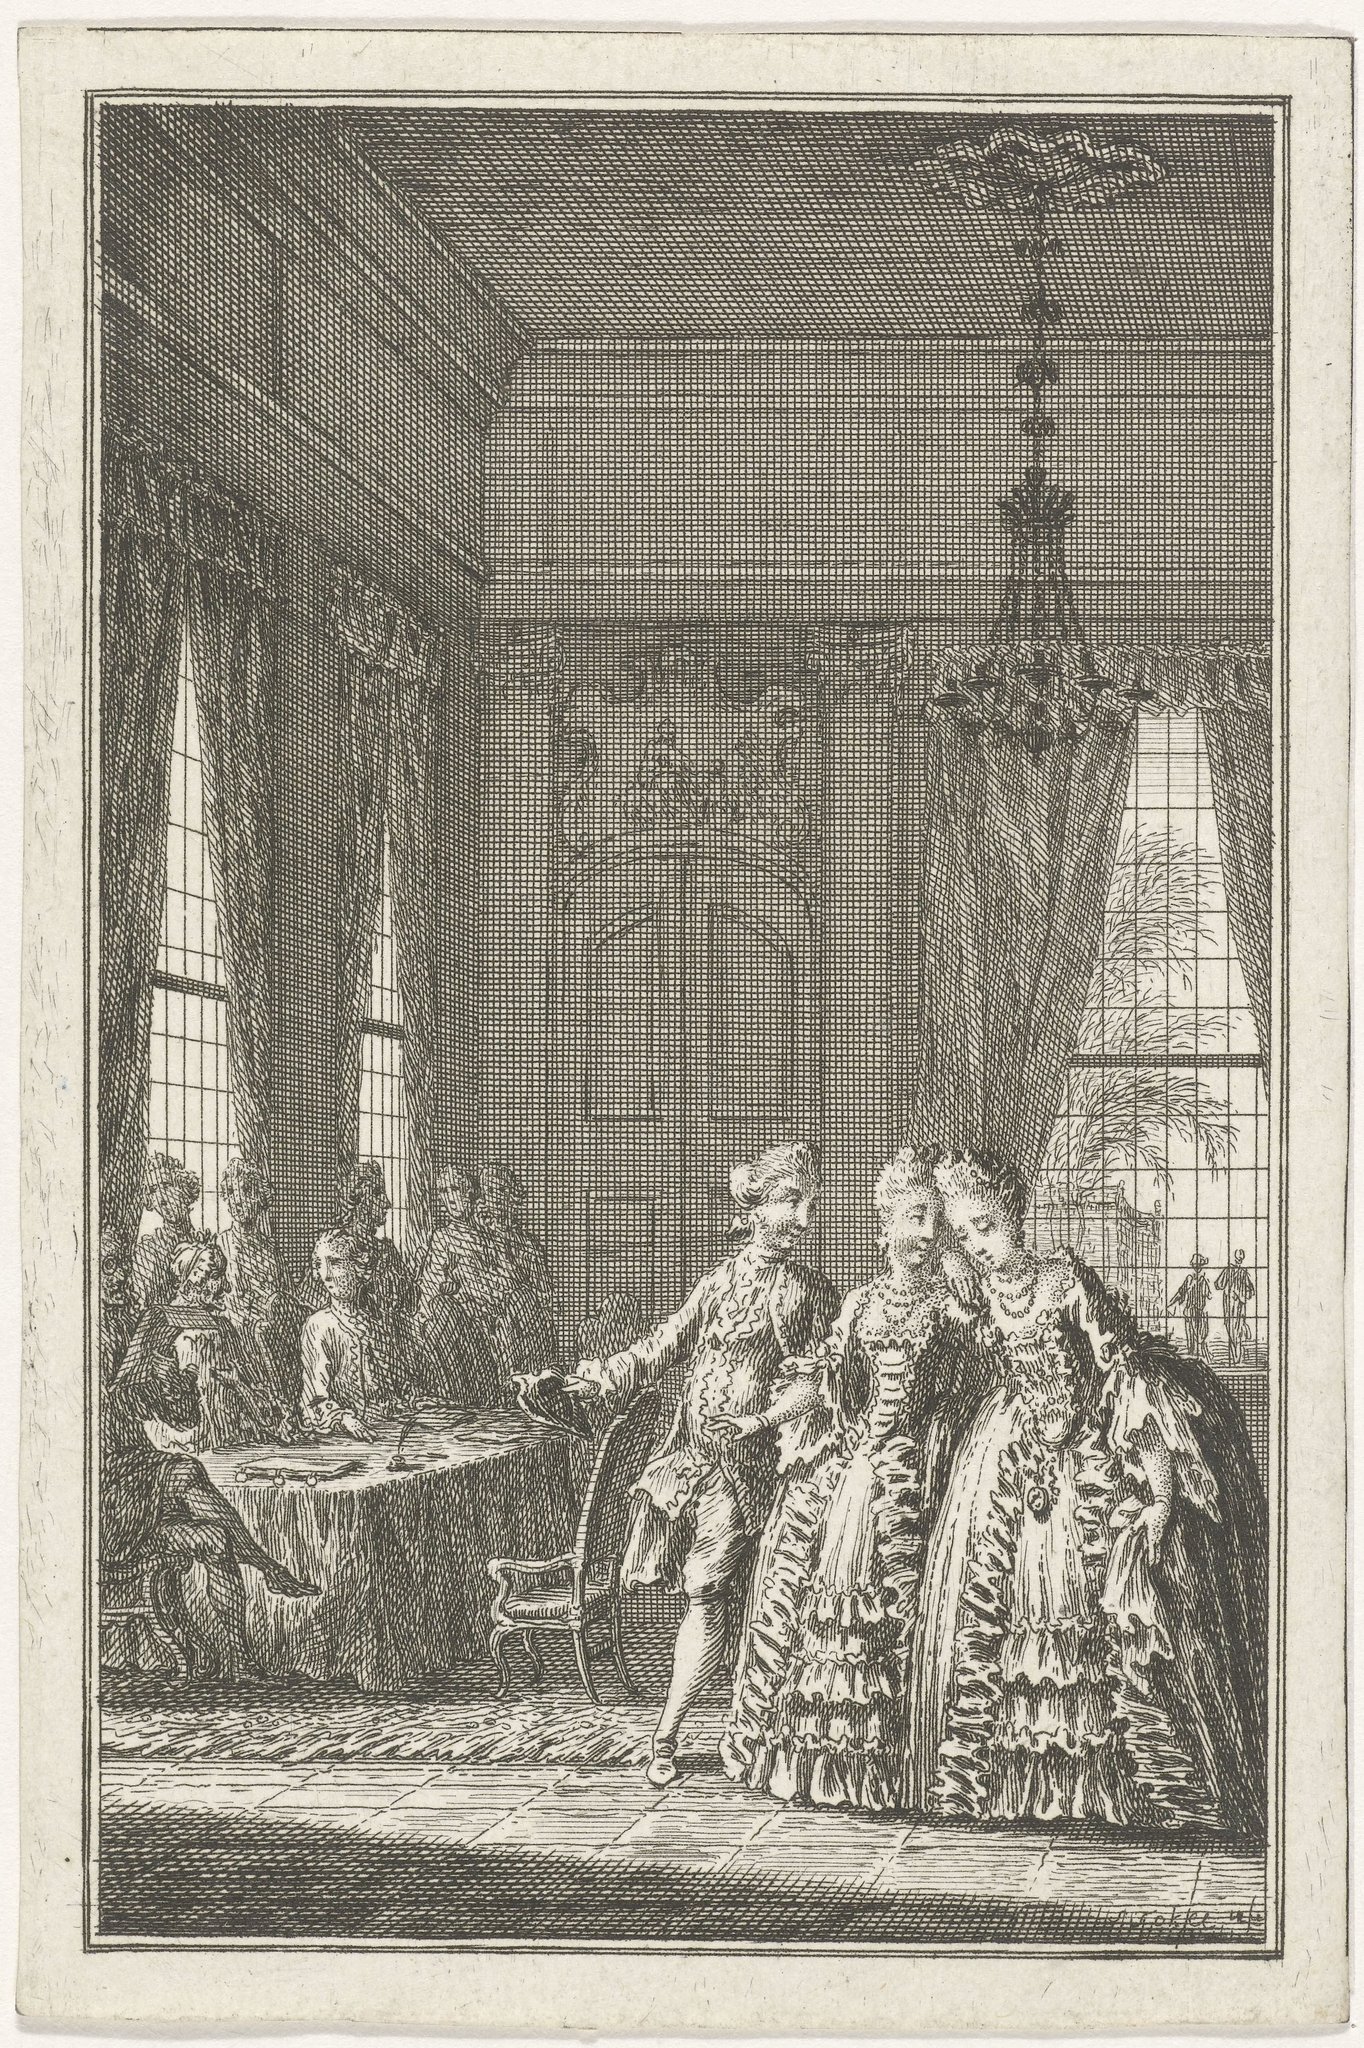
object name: print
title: Welgesteld gezelschap in een vertrek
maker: simon fokke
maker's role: draughtsman, print maker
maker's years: 1712-1784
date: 1722-1784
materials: paper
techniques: etching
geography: amsterdam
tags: visiting; receiving guests; elegant company, interior of the house, house personnel, servants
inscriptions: collector's mark: Lugt 2228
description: Een welgesteld gezelschap bevindt zich in een gemeubileerd vertrek. Op de voorgrond voegt een heer zich bij twee dames die met elkaar in gesprek zijn. Links zitten enkele figuren aan een tafel, hierachter staat een aantal bedienden opgesteld.